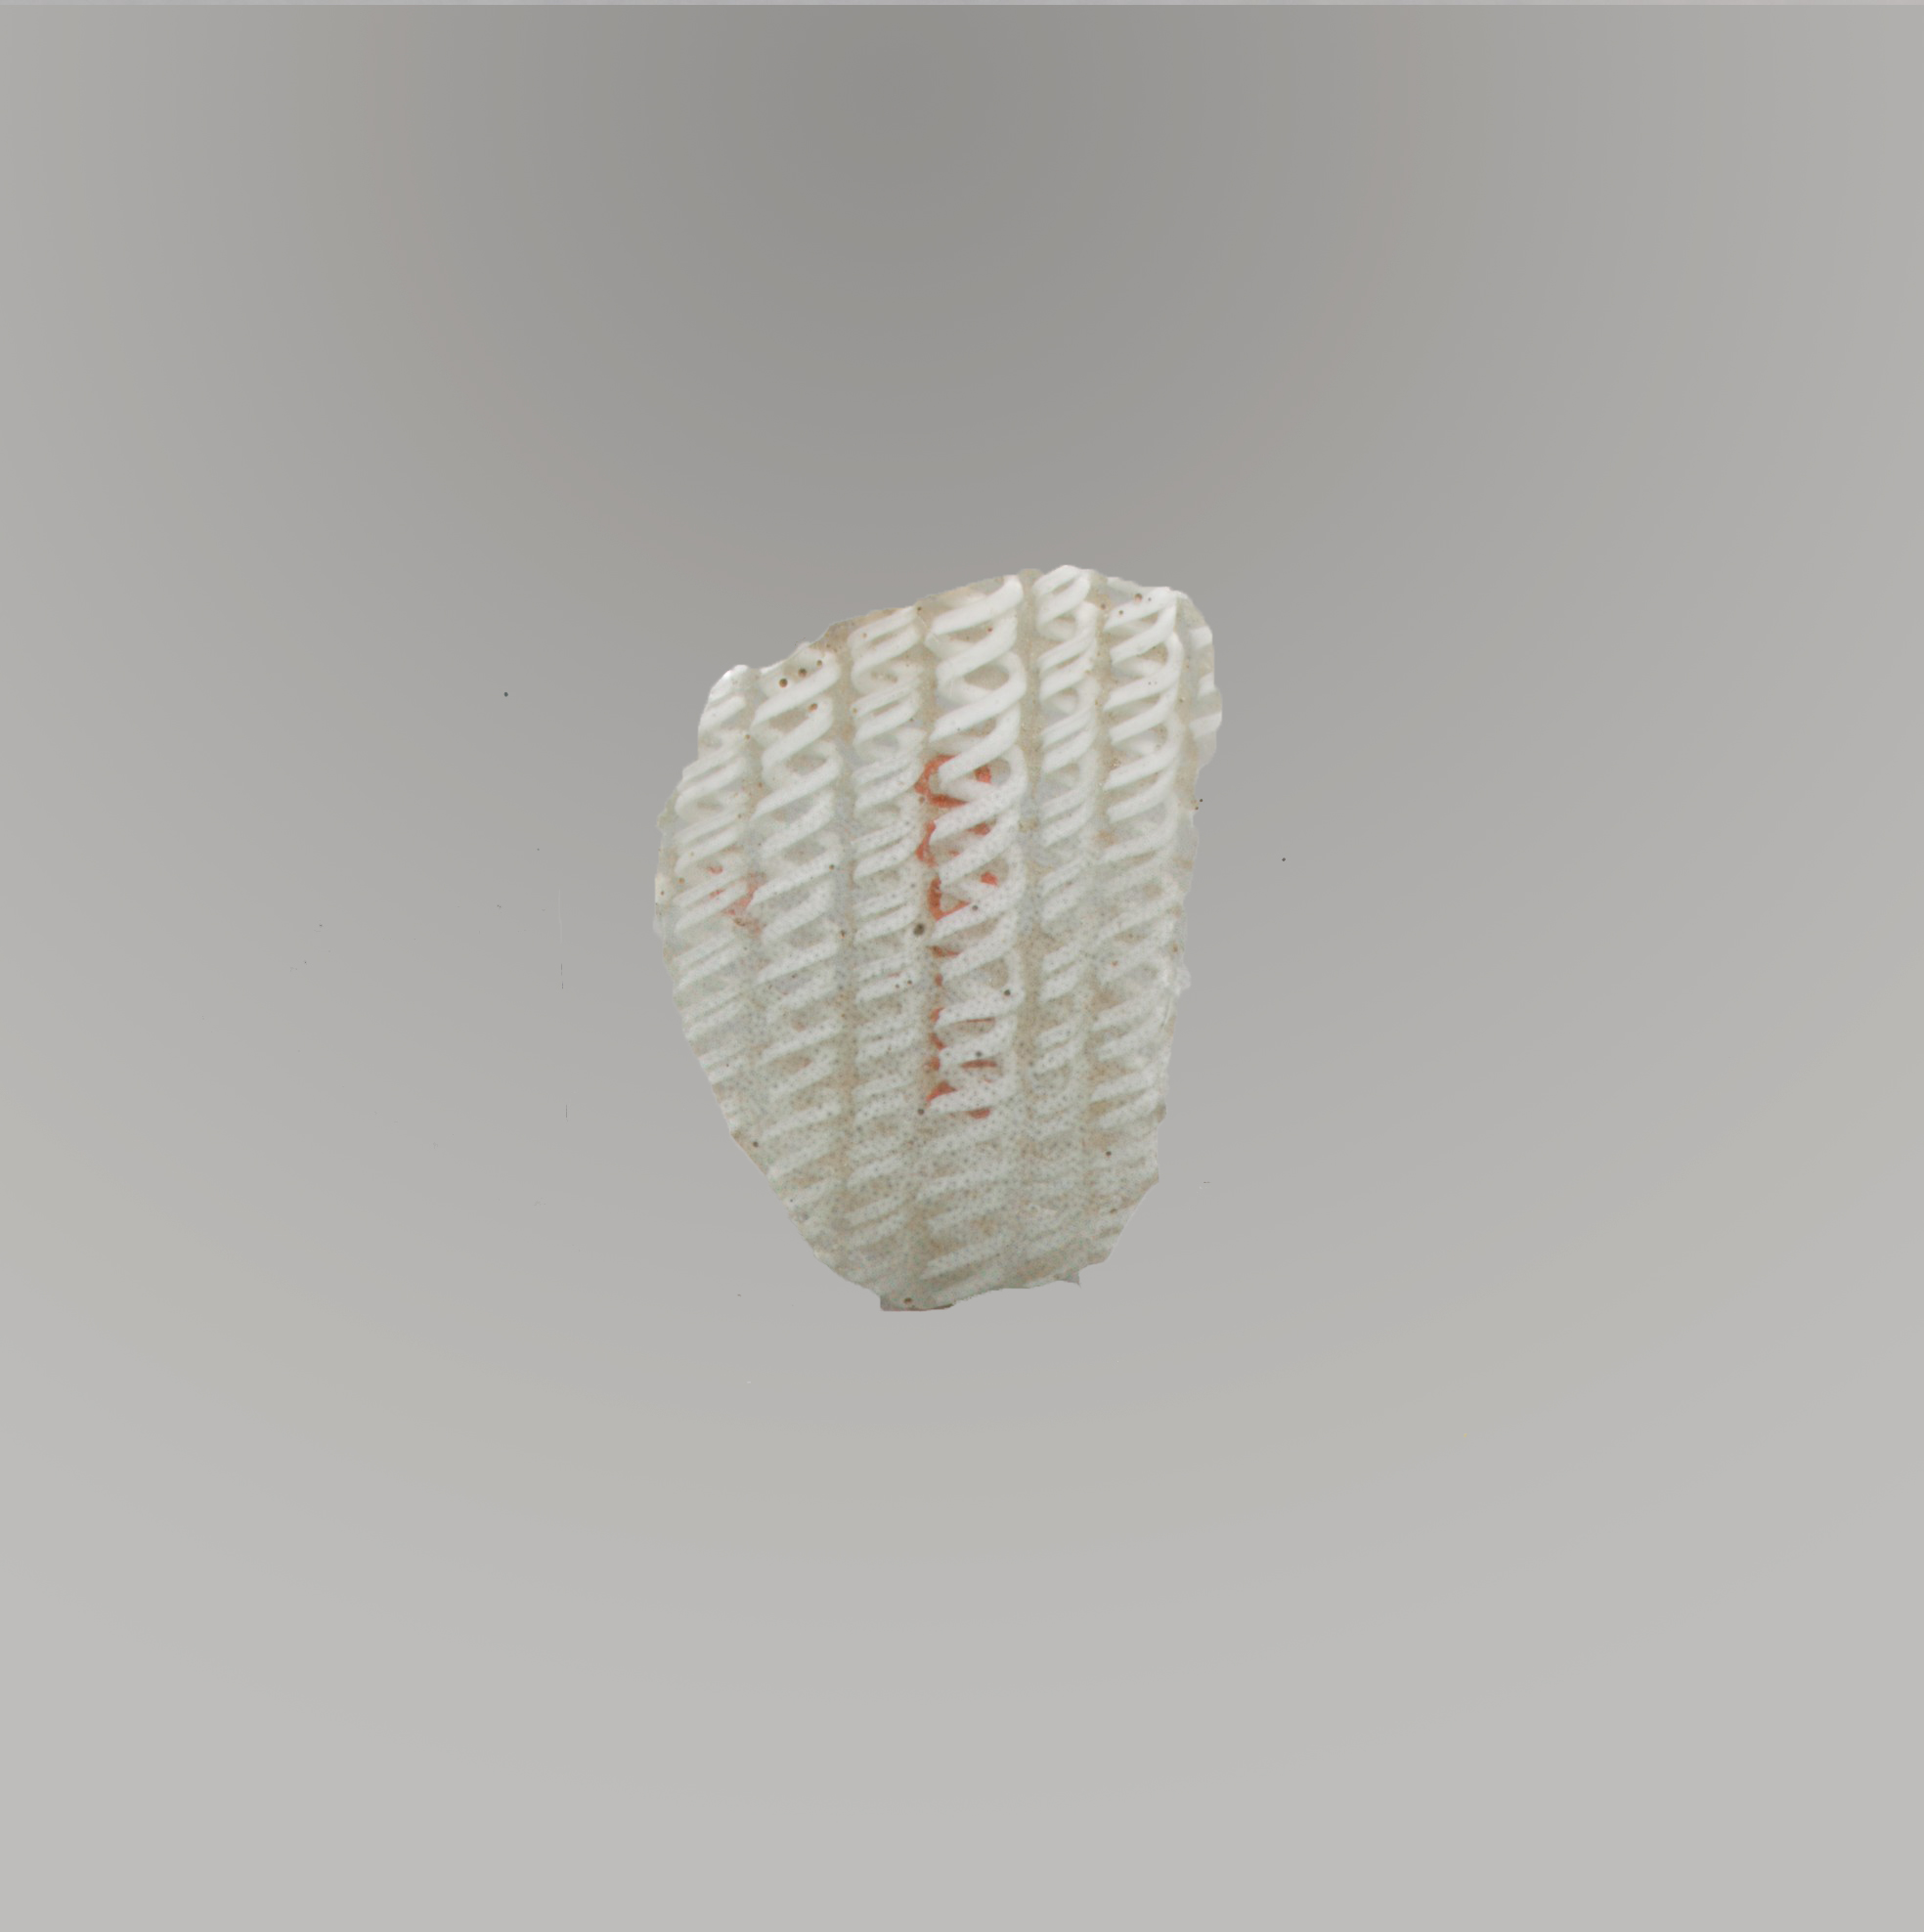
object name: fragment, network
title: Glass network mosaic fragment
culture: roman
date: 34 BCE-33 CE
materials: glass